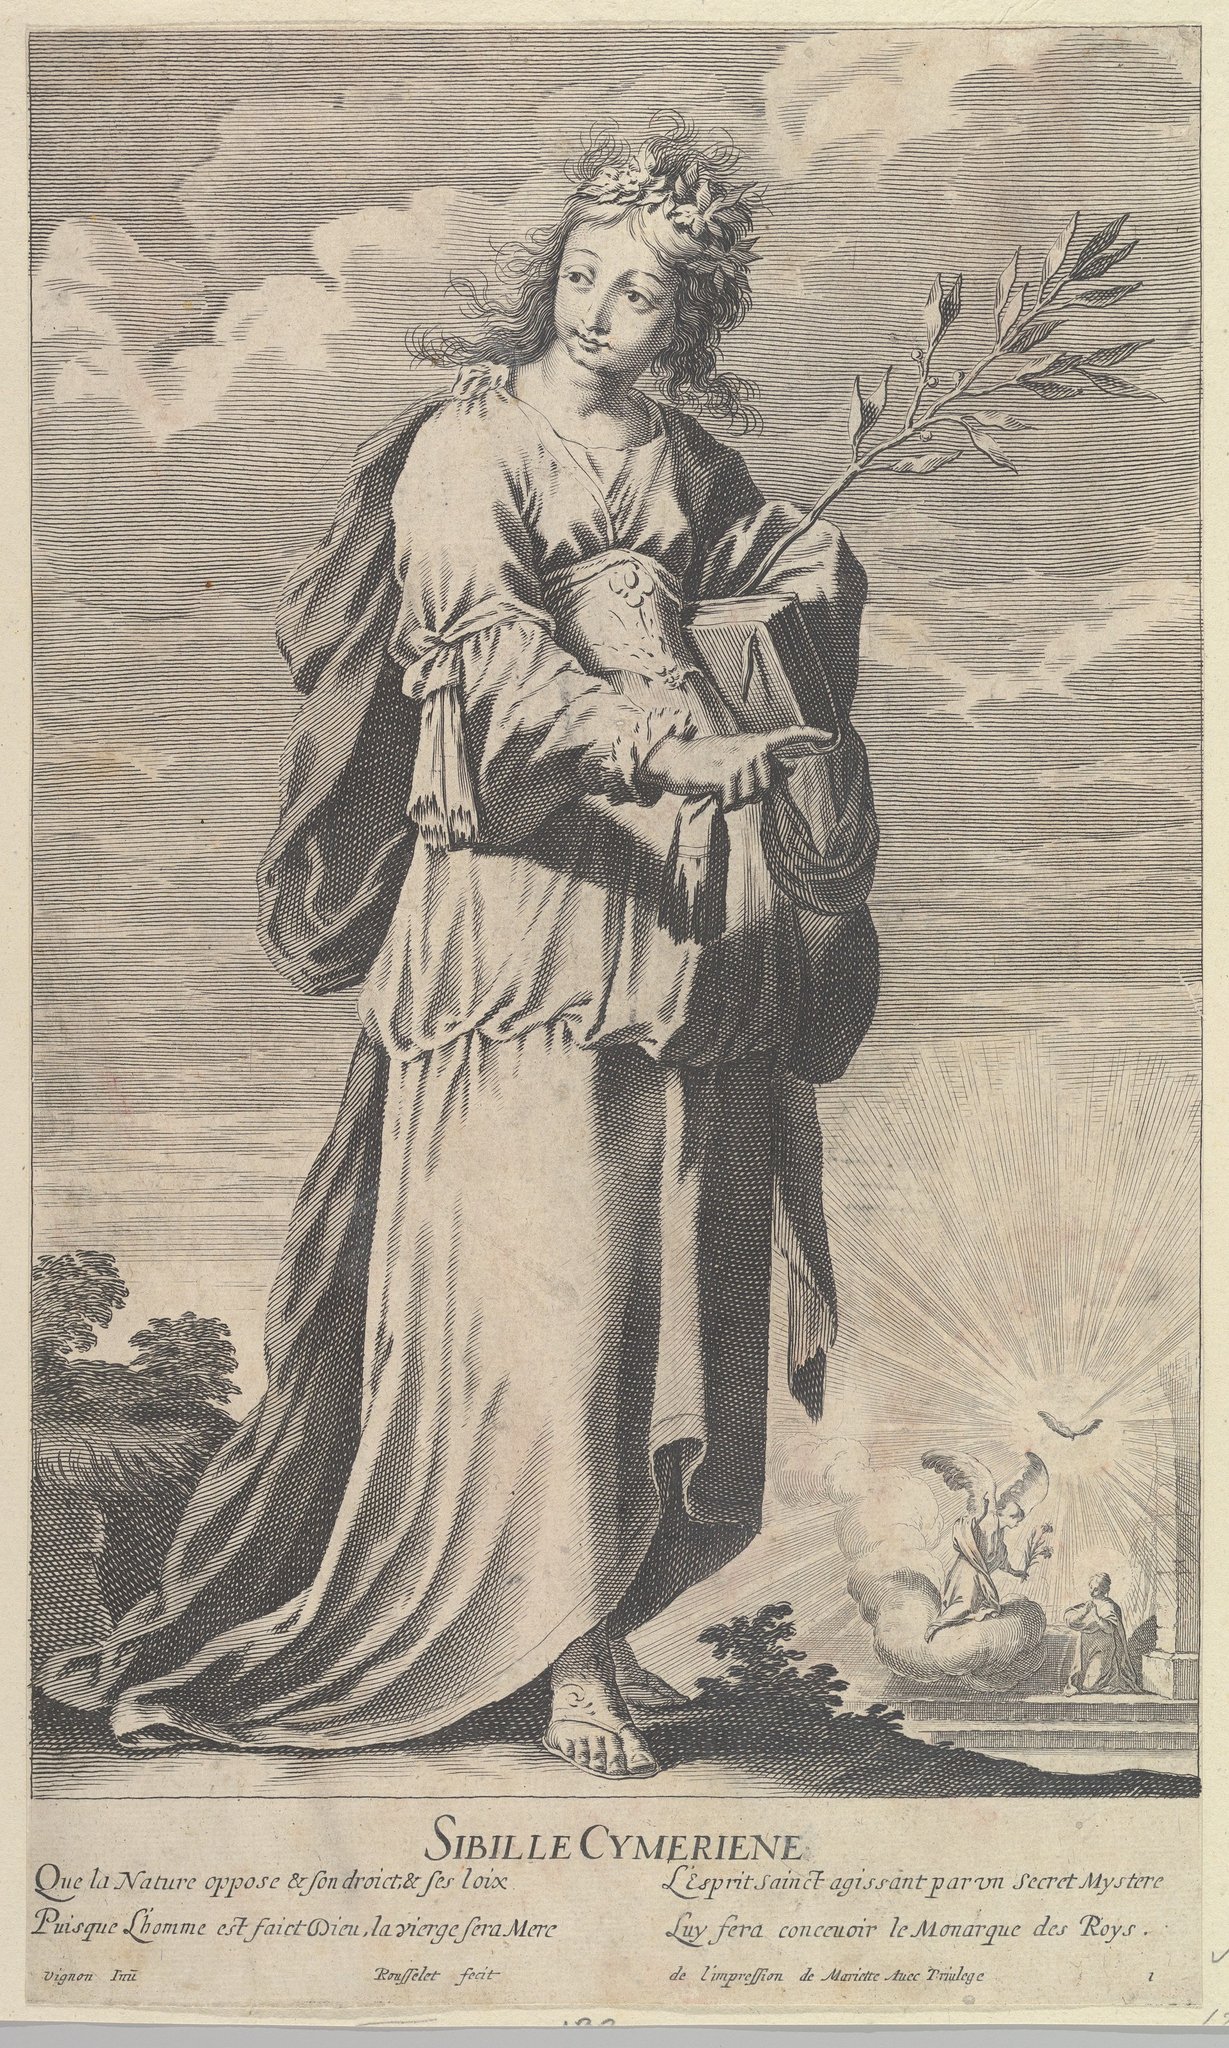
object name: print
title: Sibylle Cimmérienne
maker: gilles rousselet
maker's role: artist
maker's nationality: french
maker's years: 1614-1686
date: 1635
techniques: engraving, etching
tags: women